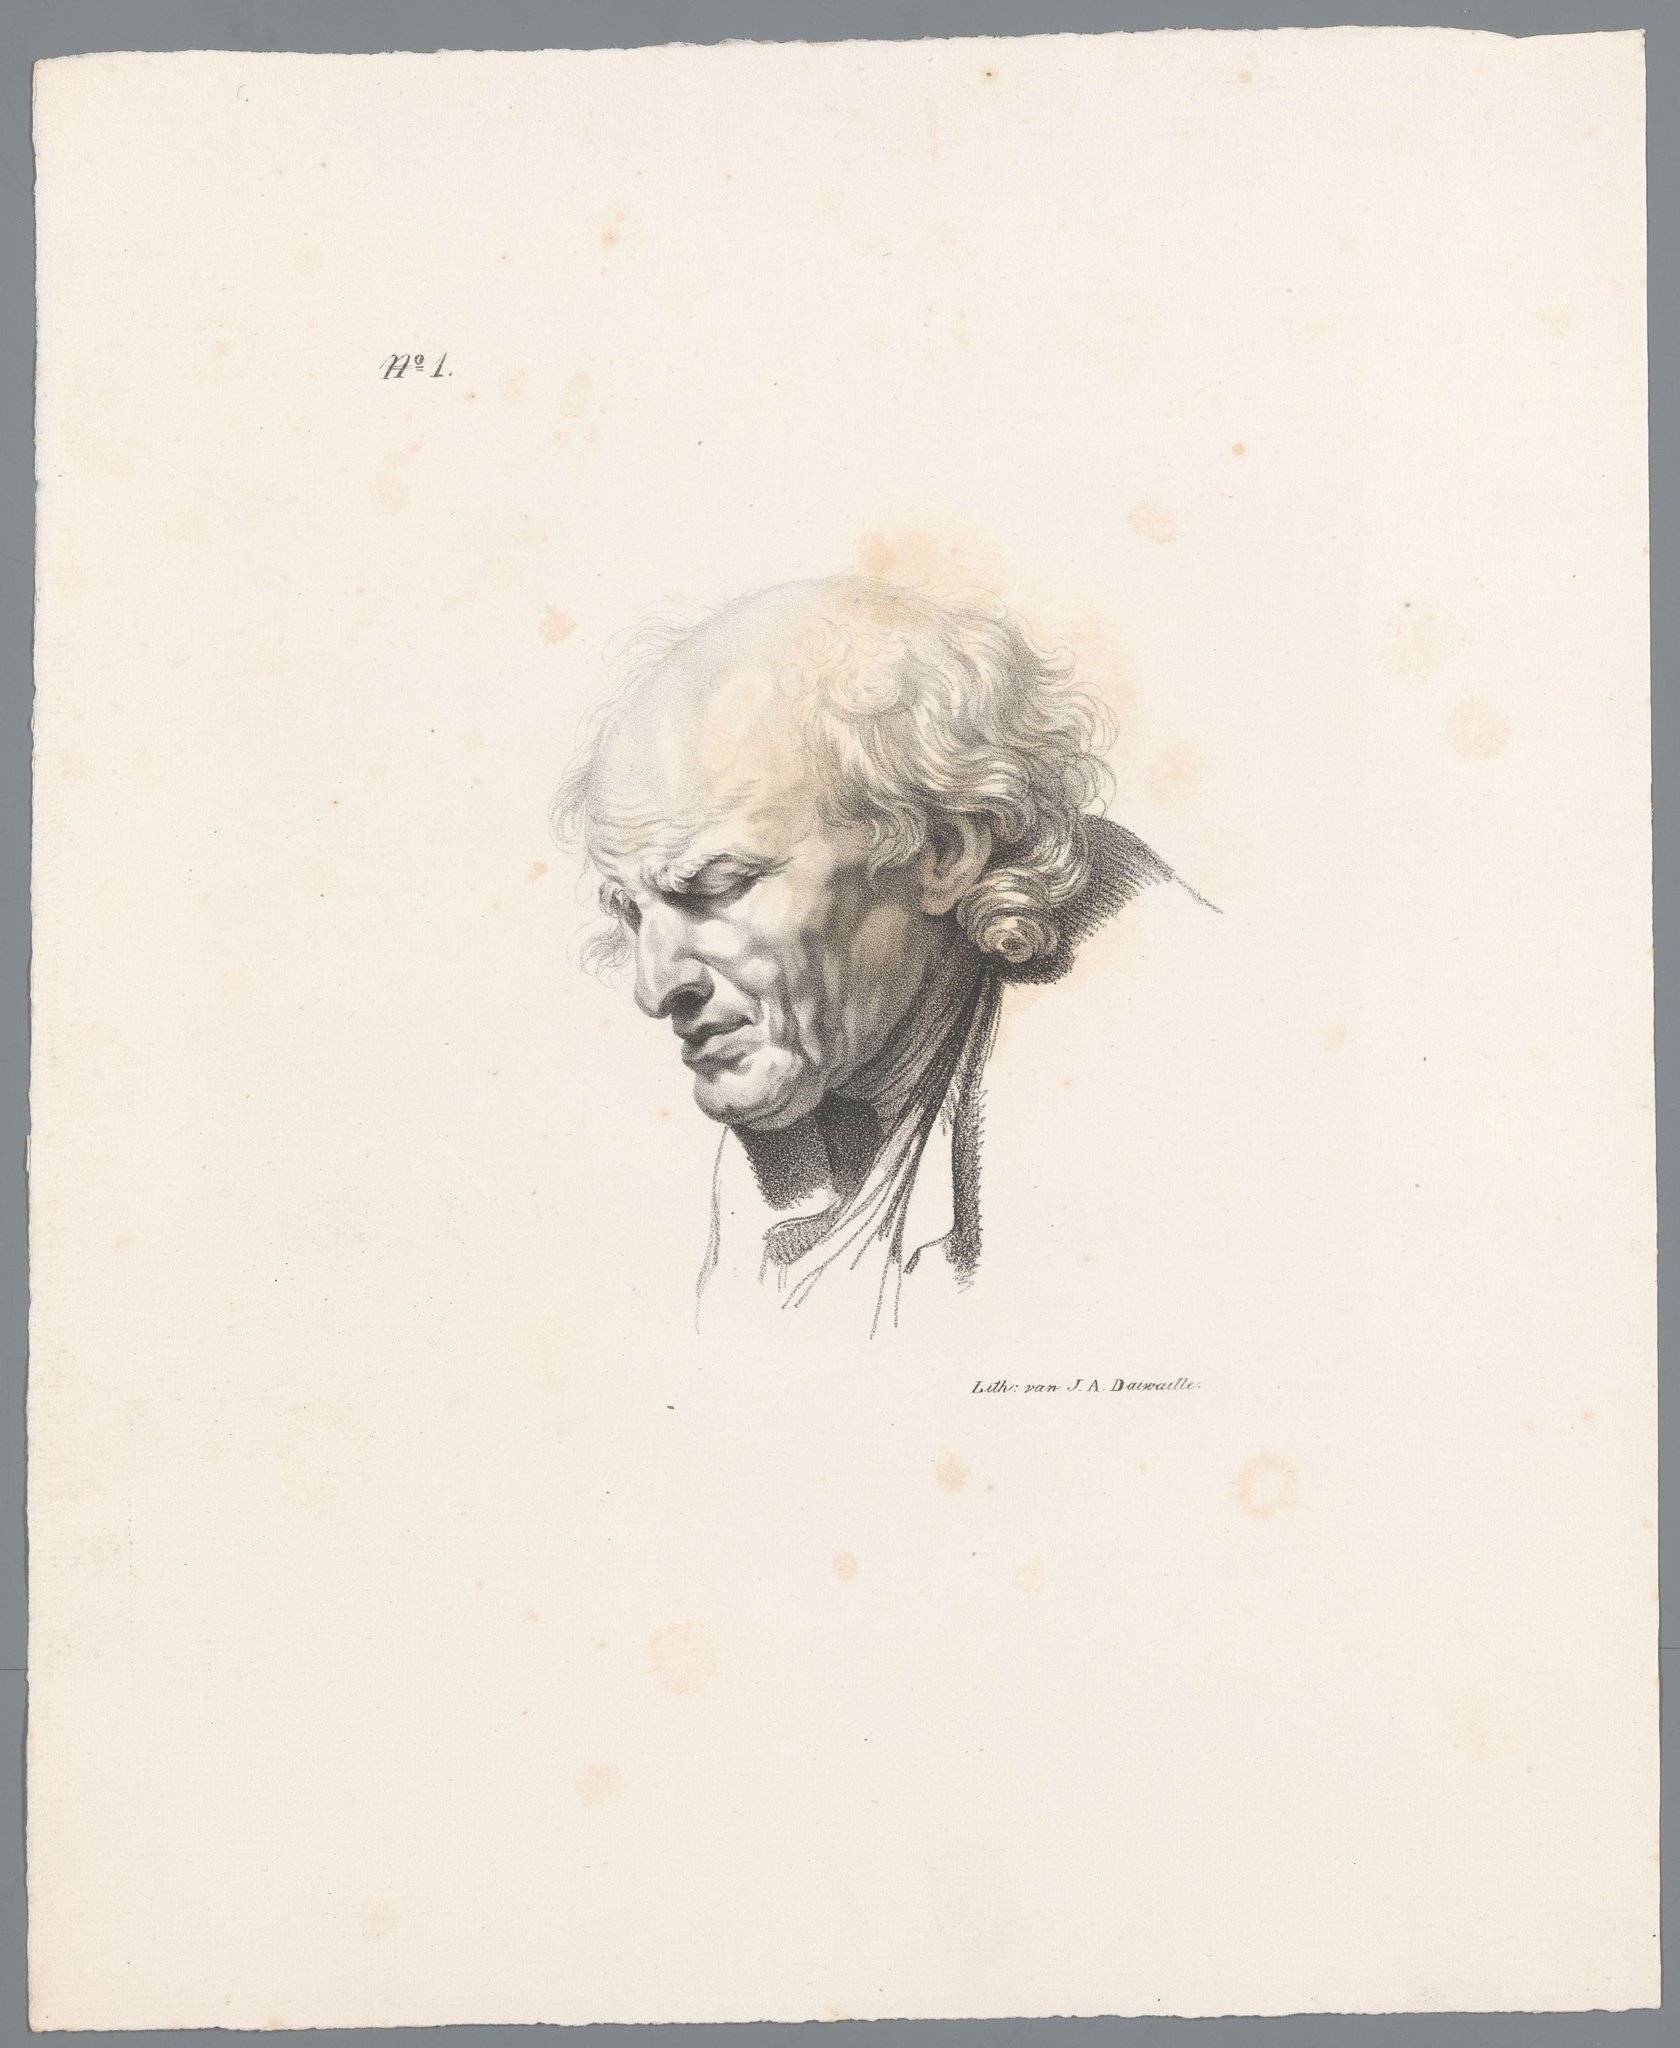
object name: print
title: Gepijnigde oude man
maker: jean augustin daiwaille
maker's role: draughtsman, print maker, printer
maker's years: 1786-1850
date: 1820-1830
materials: paper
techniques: lithograph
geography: amsterdam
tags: old man (+ relations with sad character (expressive connotations))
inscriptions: collector's mark: Lugt 2228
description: 'Hartstochten na J.B. Greuze' bestaat uit twee of drie genummerde reeksen. (Sommige nummers komen drie keer voor op drie verschillende afbeeldingen.) Binnen deze omslag bevinden zich achttien verschillende afbeeldingen. Mogelijk heeft dit te maken met de twee momenten waarop Daiwaille de reeks uitgaf, ten tijden van zijn directeurschap aan de Rijksakademie in Amsterdam en daarna als zelfstandige. De omslag behoort waarschijnlijk bij een van deze twee series. Zie Marres-Schretlen in het Bulletin van het Rijksmuseum.